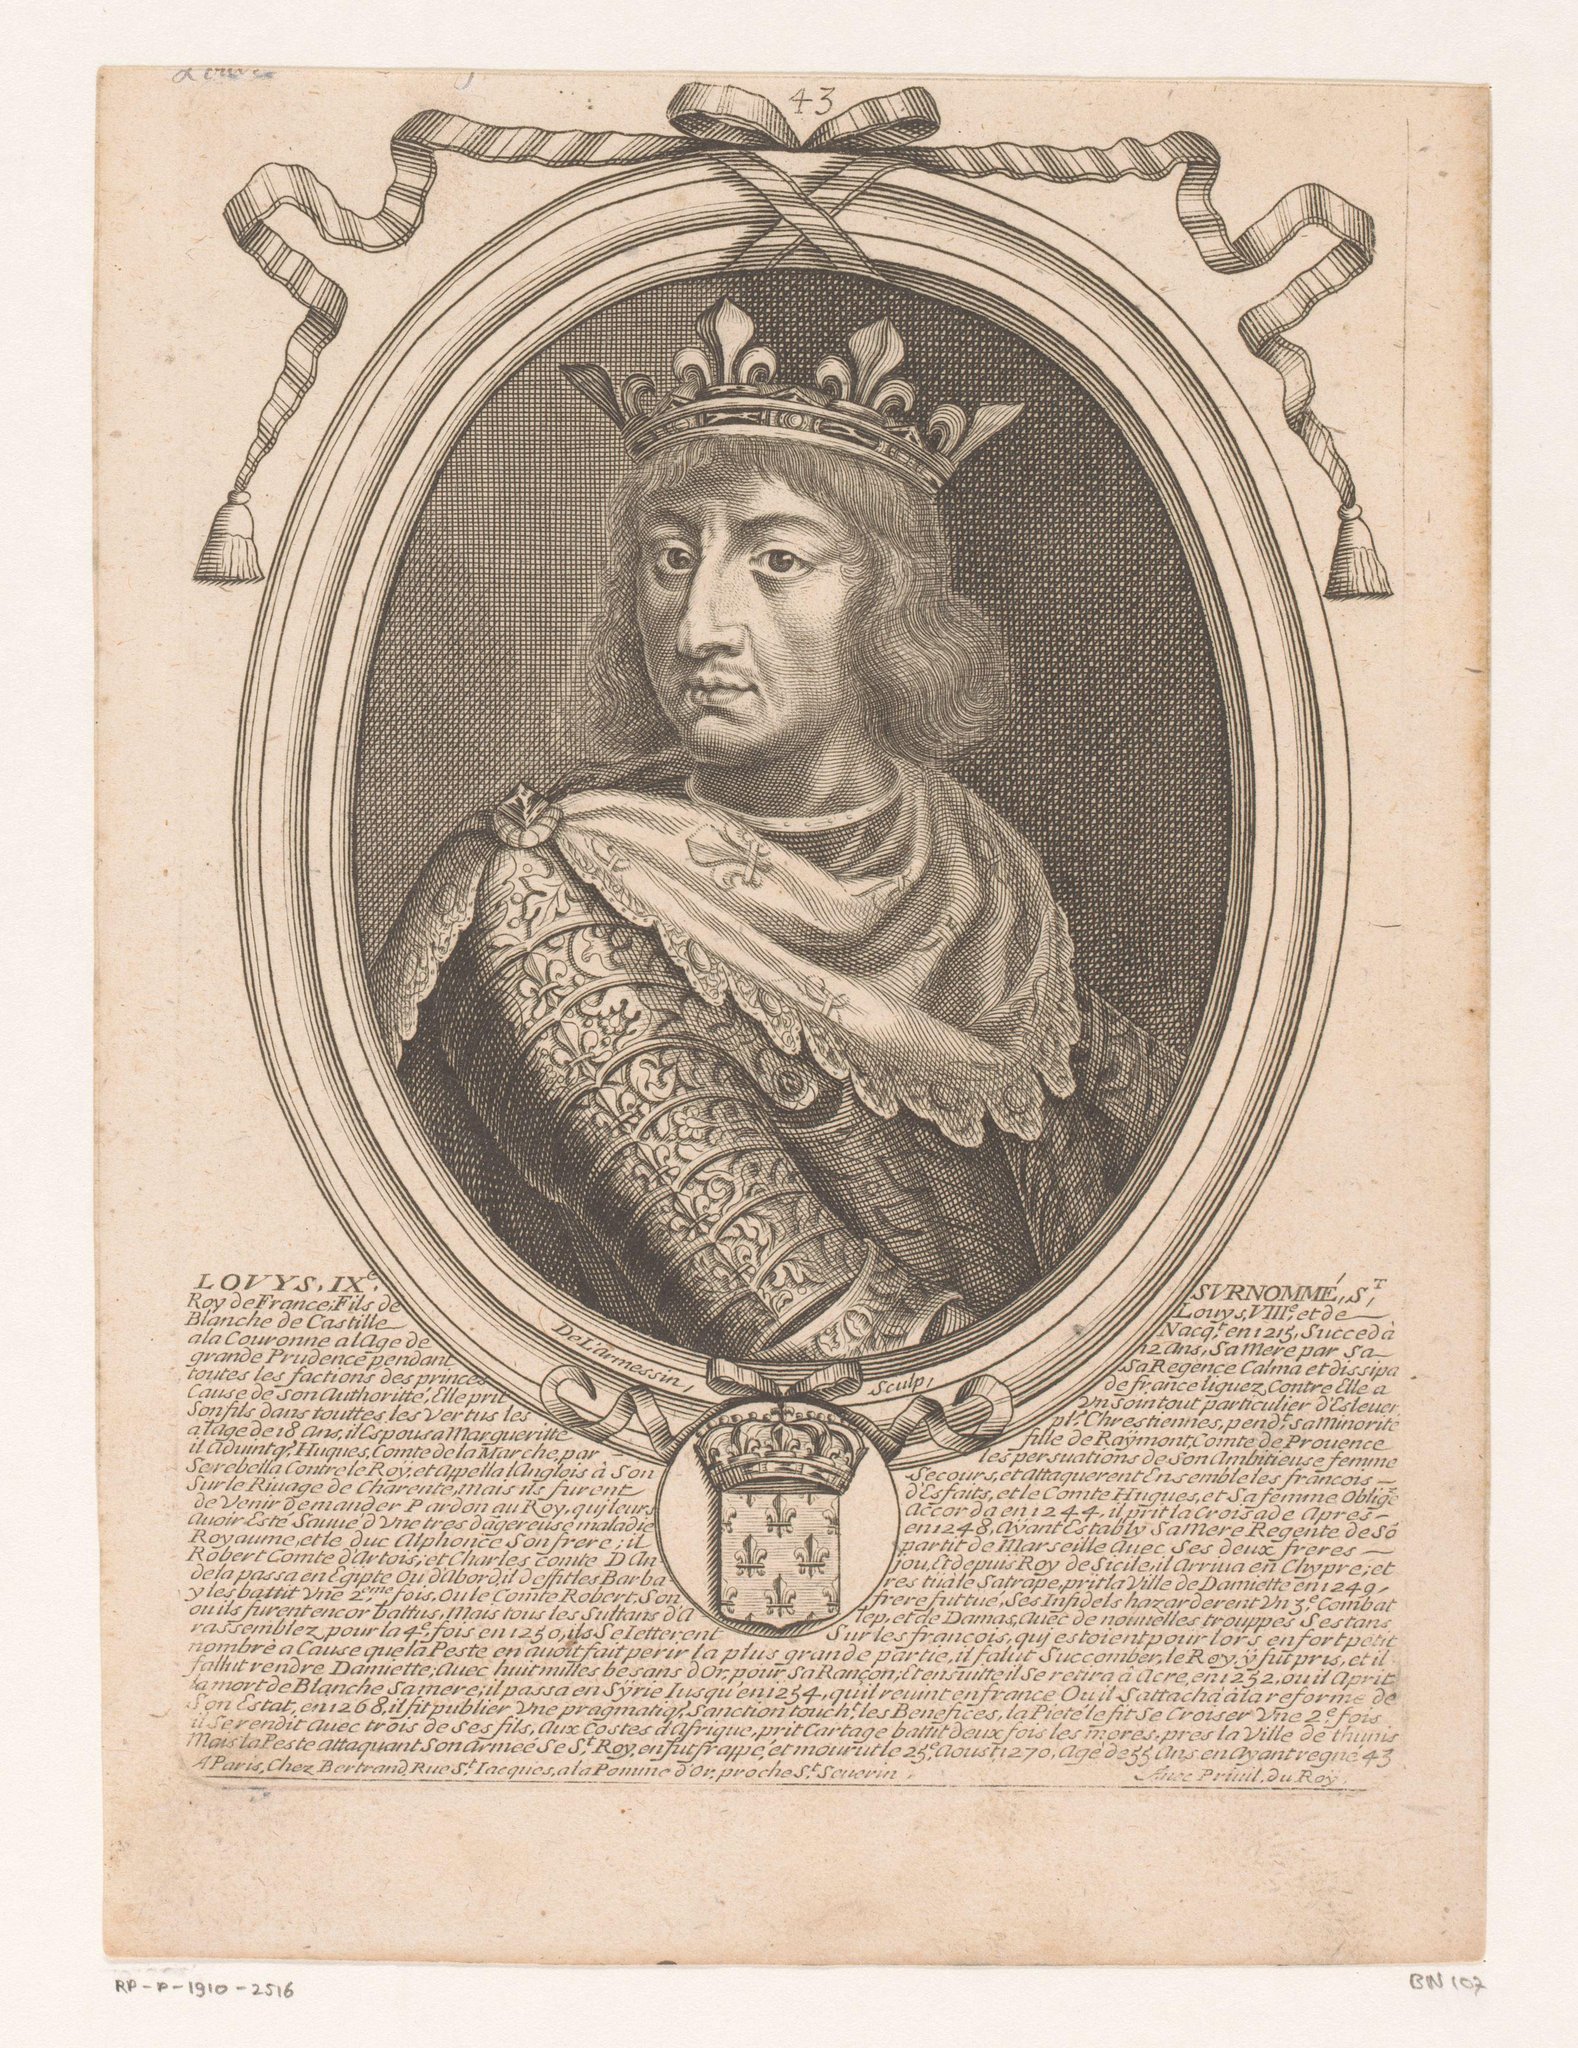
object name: print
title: Portretten van prominente figuren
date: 1642-1678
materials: paper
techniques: engraving, etching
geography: paris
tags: historical persons, king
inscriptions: collector's mark: Lugt 2228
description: Maakt deel uit van een grootschalige serie met portretten van prominente figuren. Binnen de serie bevindt zich een sectie getiteld 'Les Augustes Représentations De tous les Roys De France depuis Pharamond Iusqu'à Louys XIIII'. De serie werd respectievelijk uitgegeven door Pierre Bertrand, door zijn weduwe en door De Larmessin zelf.